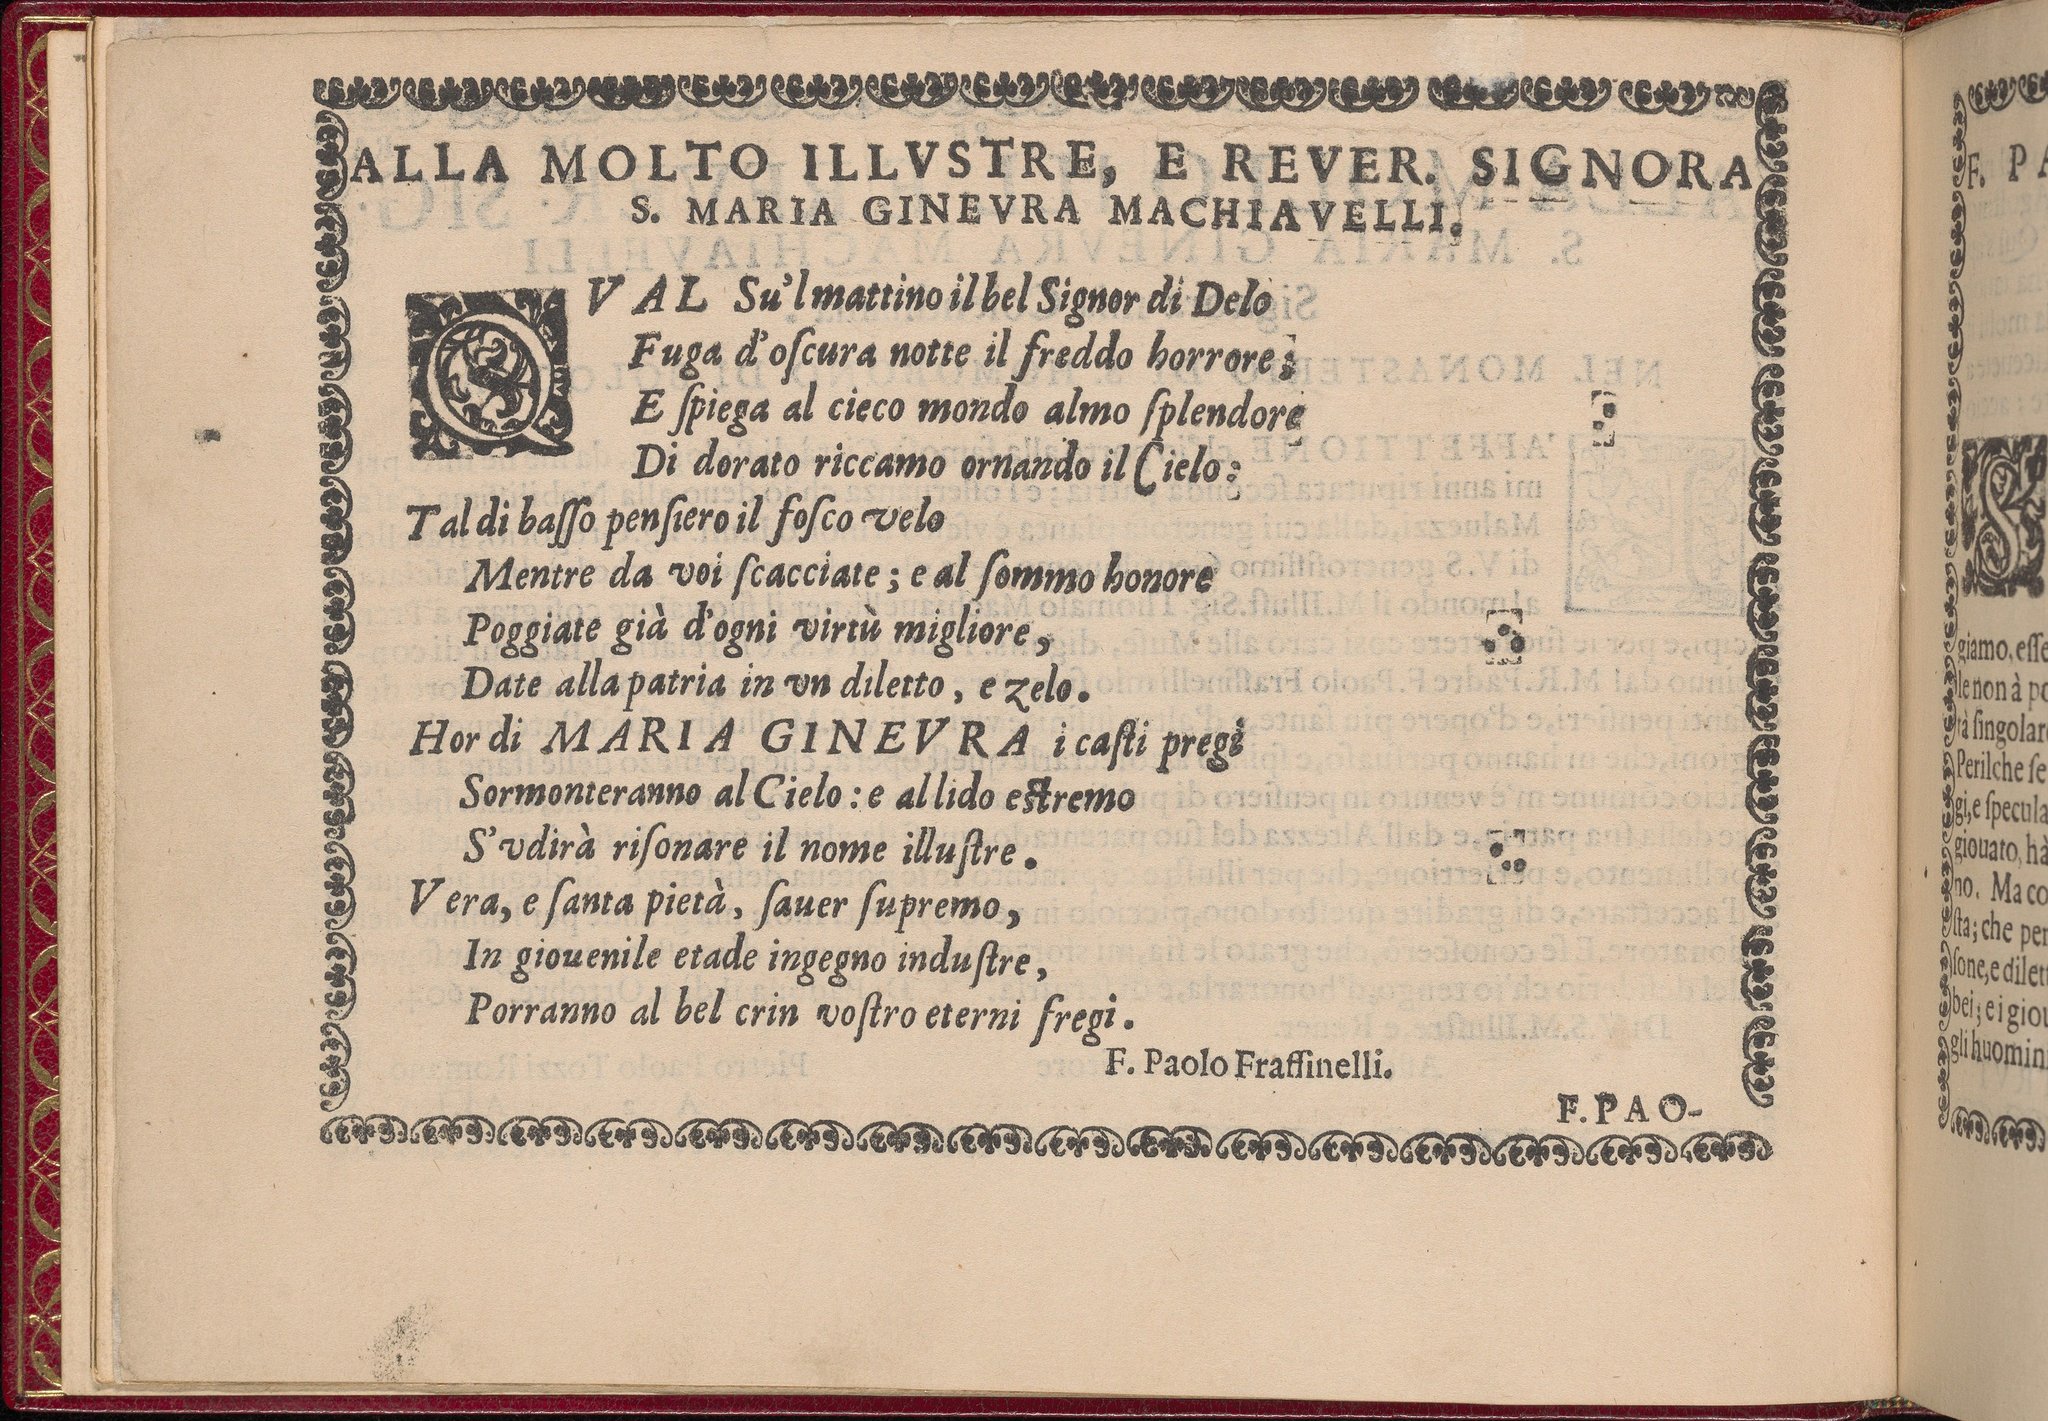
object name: book print ornament architecture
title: Ghirlanda: Di sei vaghi fiori scielti da piu famosi Giardini d'Italia, page 2 (verso)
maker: pietro paulo tozzi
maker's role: designer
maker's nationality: italian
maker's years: 1593-1628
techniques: drawing, etching